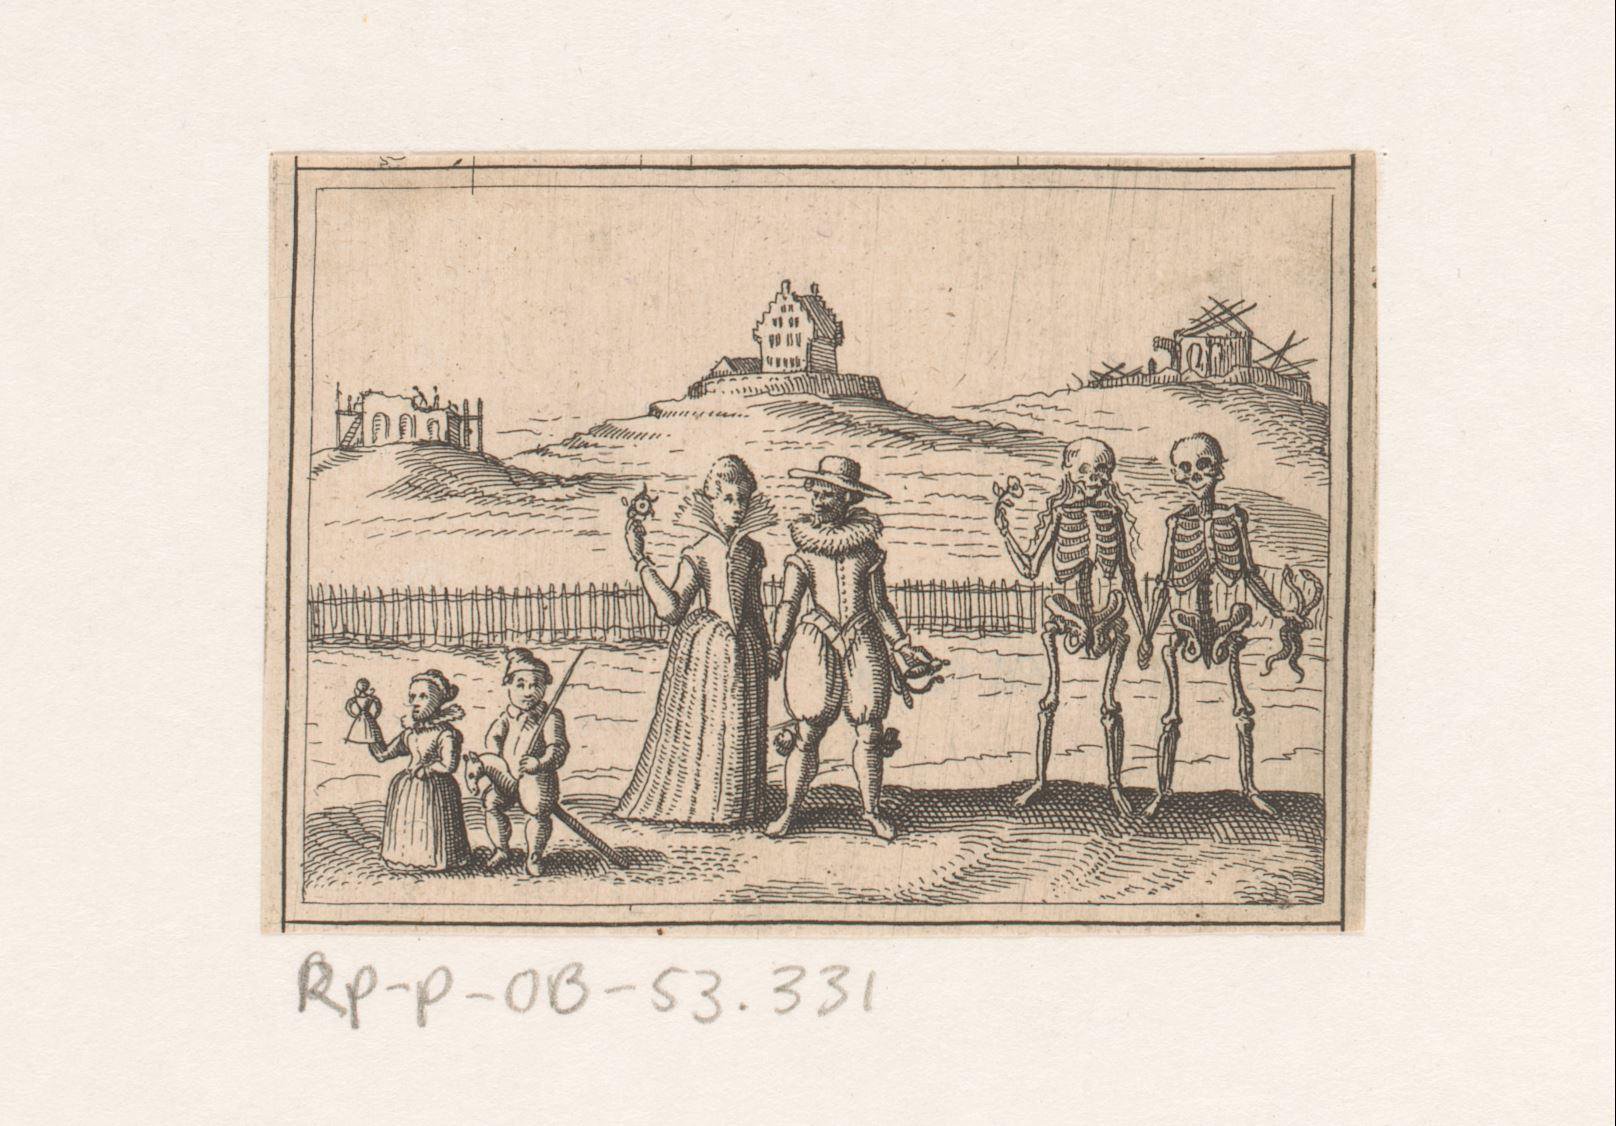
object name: book illustration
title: Drie levensfasen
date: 1624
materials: paper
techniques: etching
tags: adult woman, the course of life symbolized, death as skeleton, adult man, the usual house or row of houses, civic architecture; edifices; dwellings, ruin of a dwelling, house, castle, etc., child (at home)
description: Prent uit: Sudermann, Daniel. Centuria Similitudinum, Hubert Gleichnussen. Straatsburg, Jacob van der Heyden, 1624. (Hollstein German XXVIA 646).